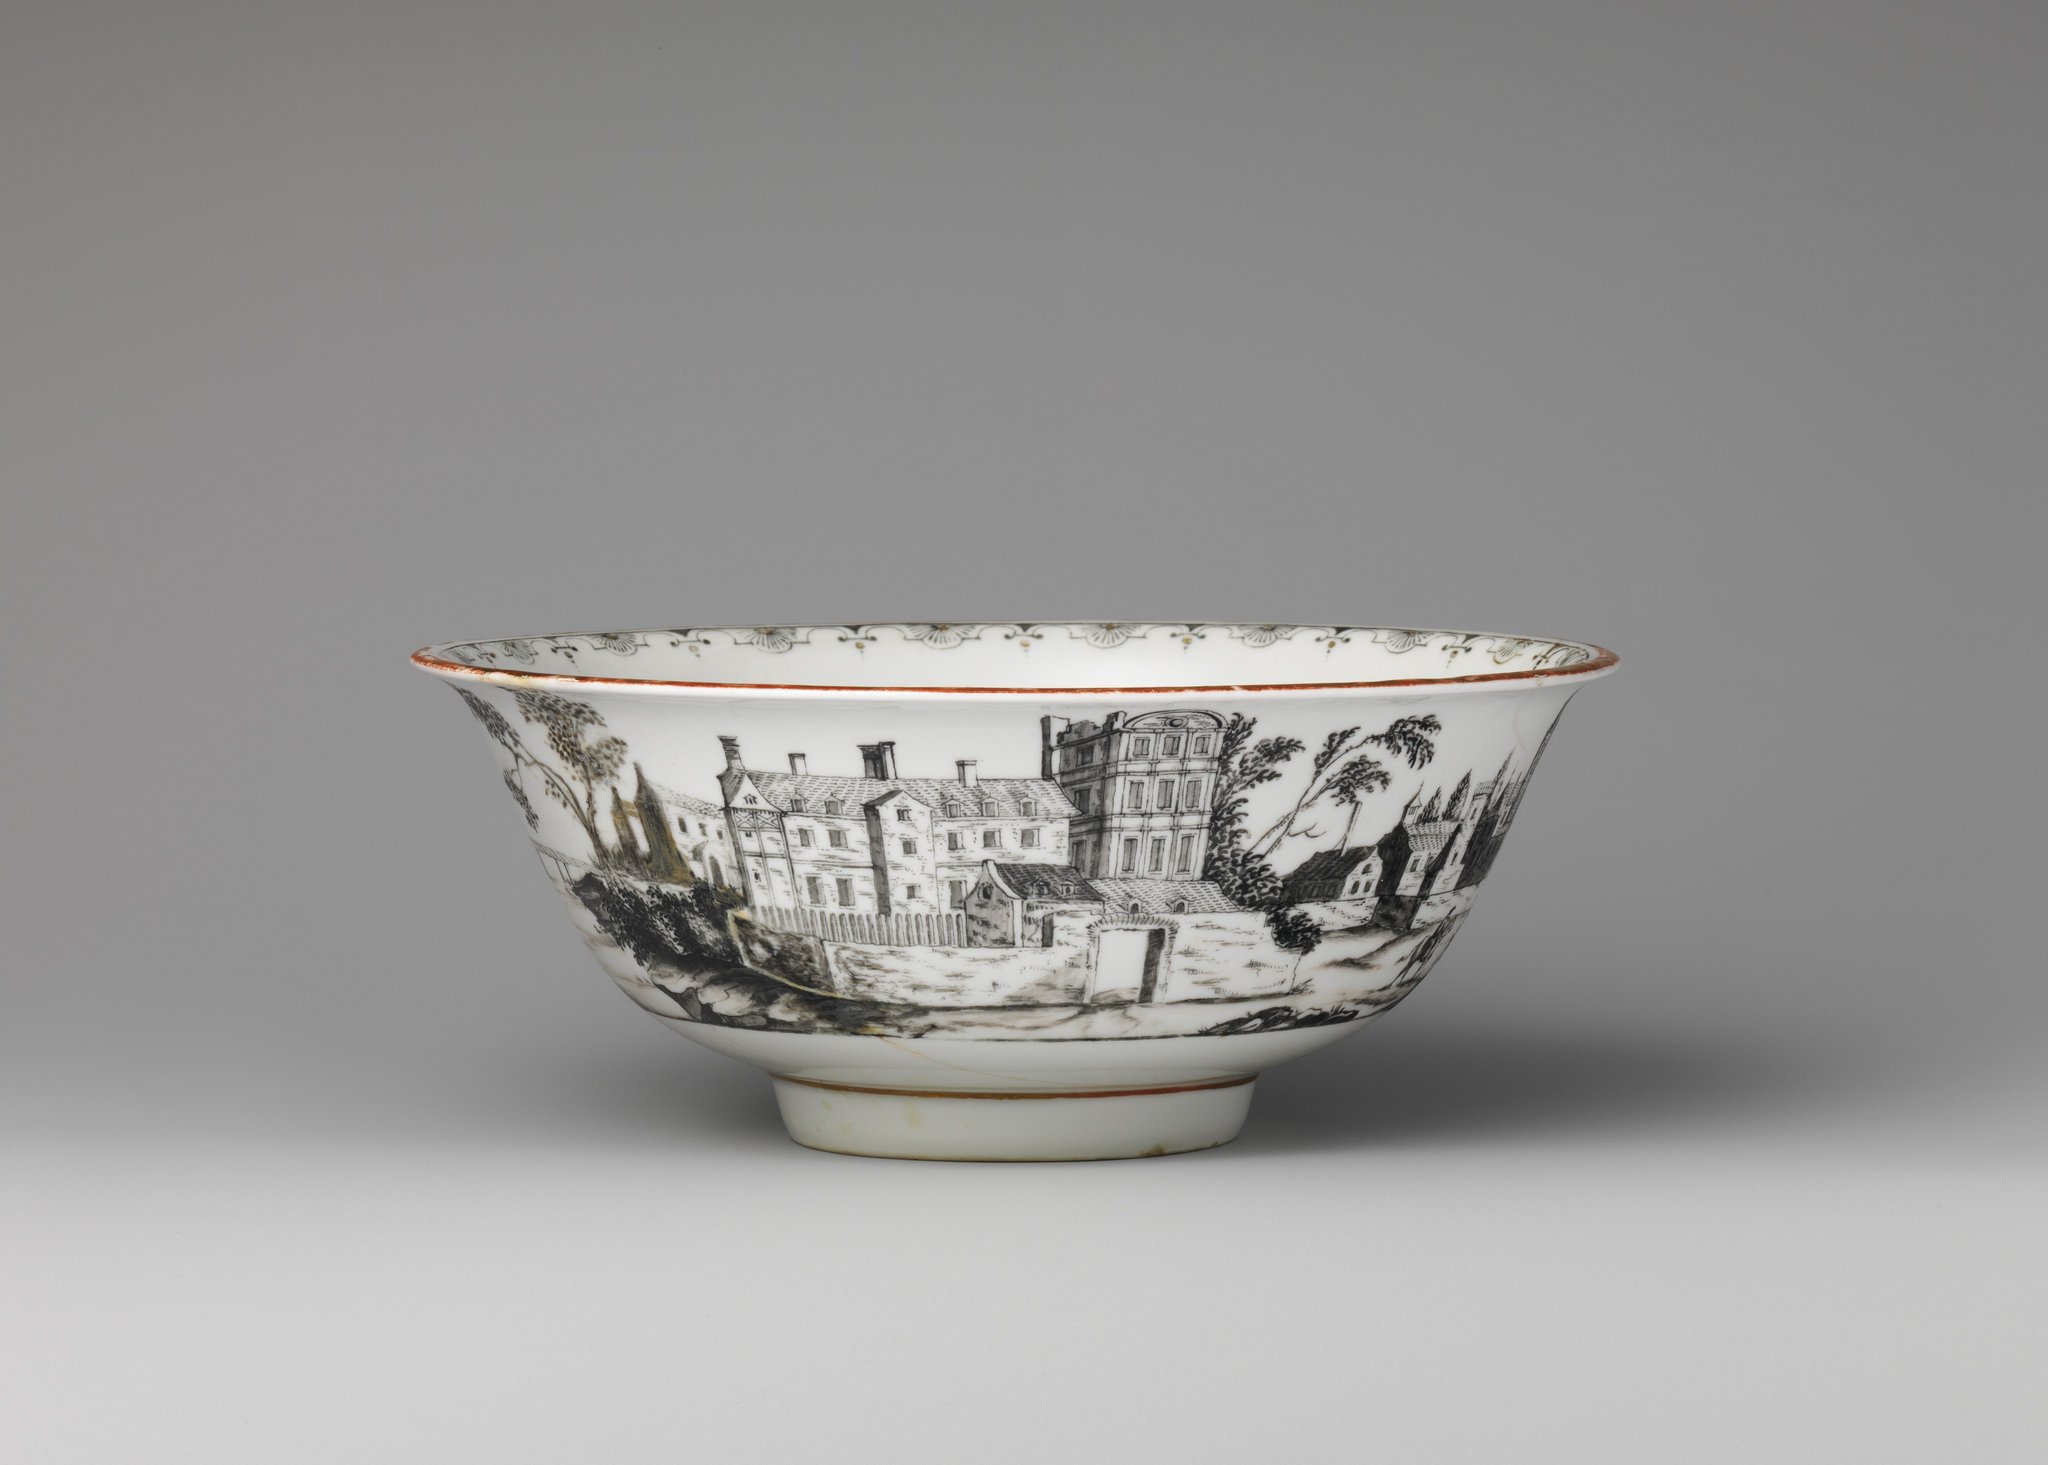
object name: slop bowl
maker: vienna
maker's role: manufactory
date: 1735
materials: hard paste porcelain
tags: buildings